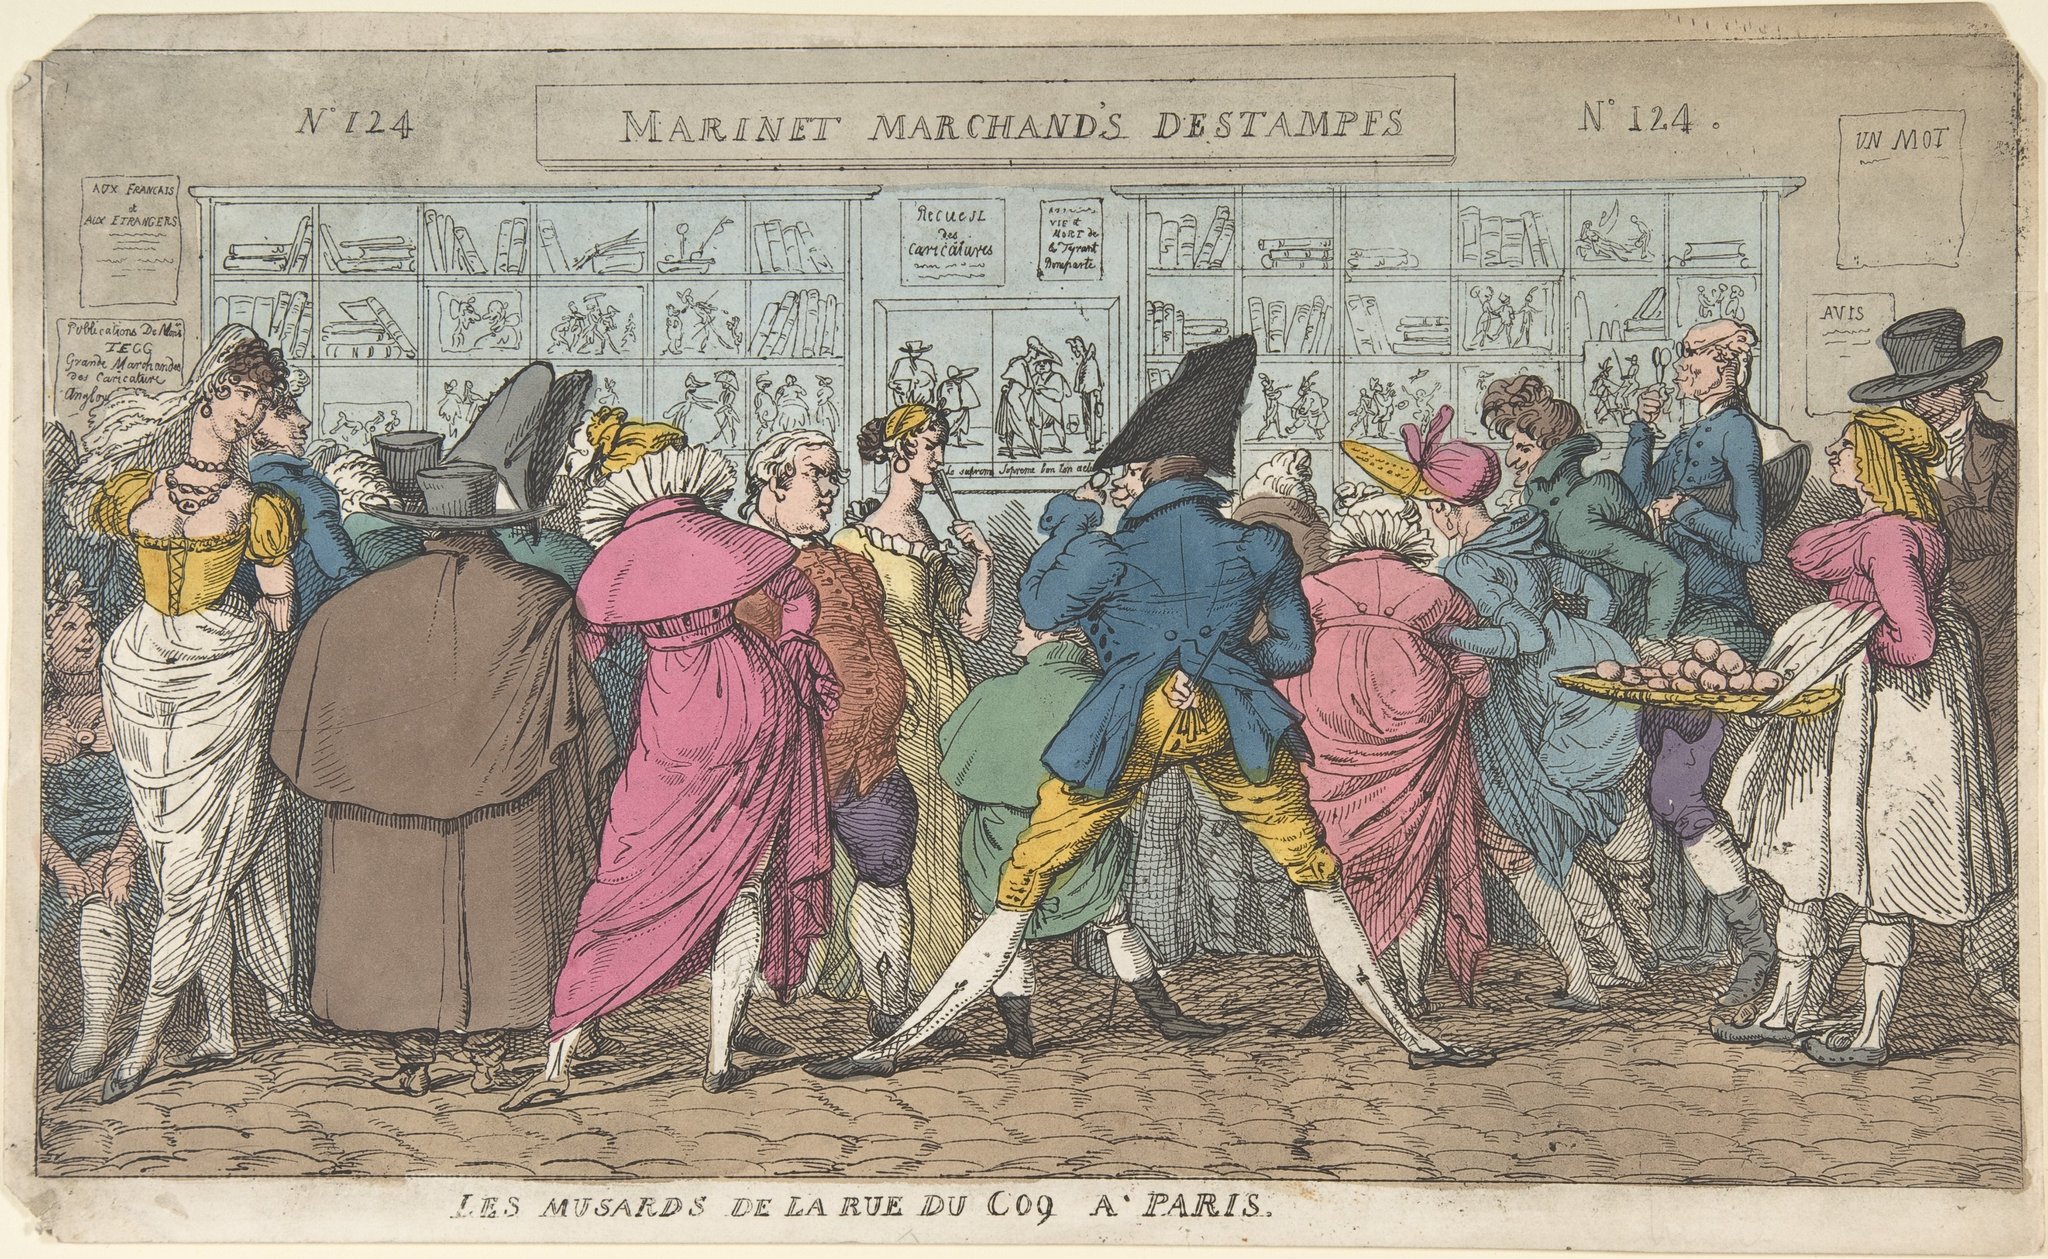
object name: print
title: Les Musards de la Rue du Coq à Paris (Dawdlers of the Rue Coq, Paris)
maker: thomas rowlandson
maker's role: artist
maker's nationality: british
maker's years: 1757-1827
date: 1810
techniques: etching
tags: men,women,crowd